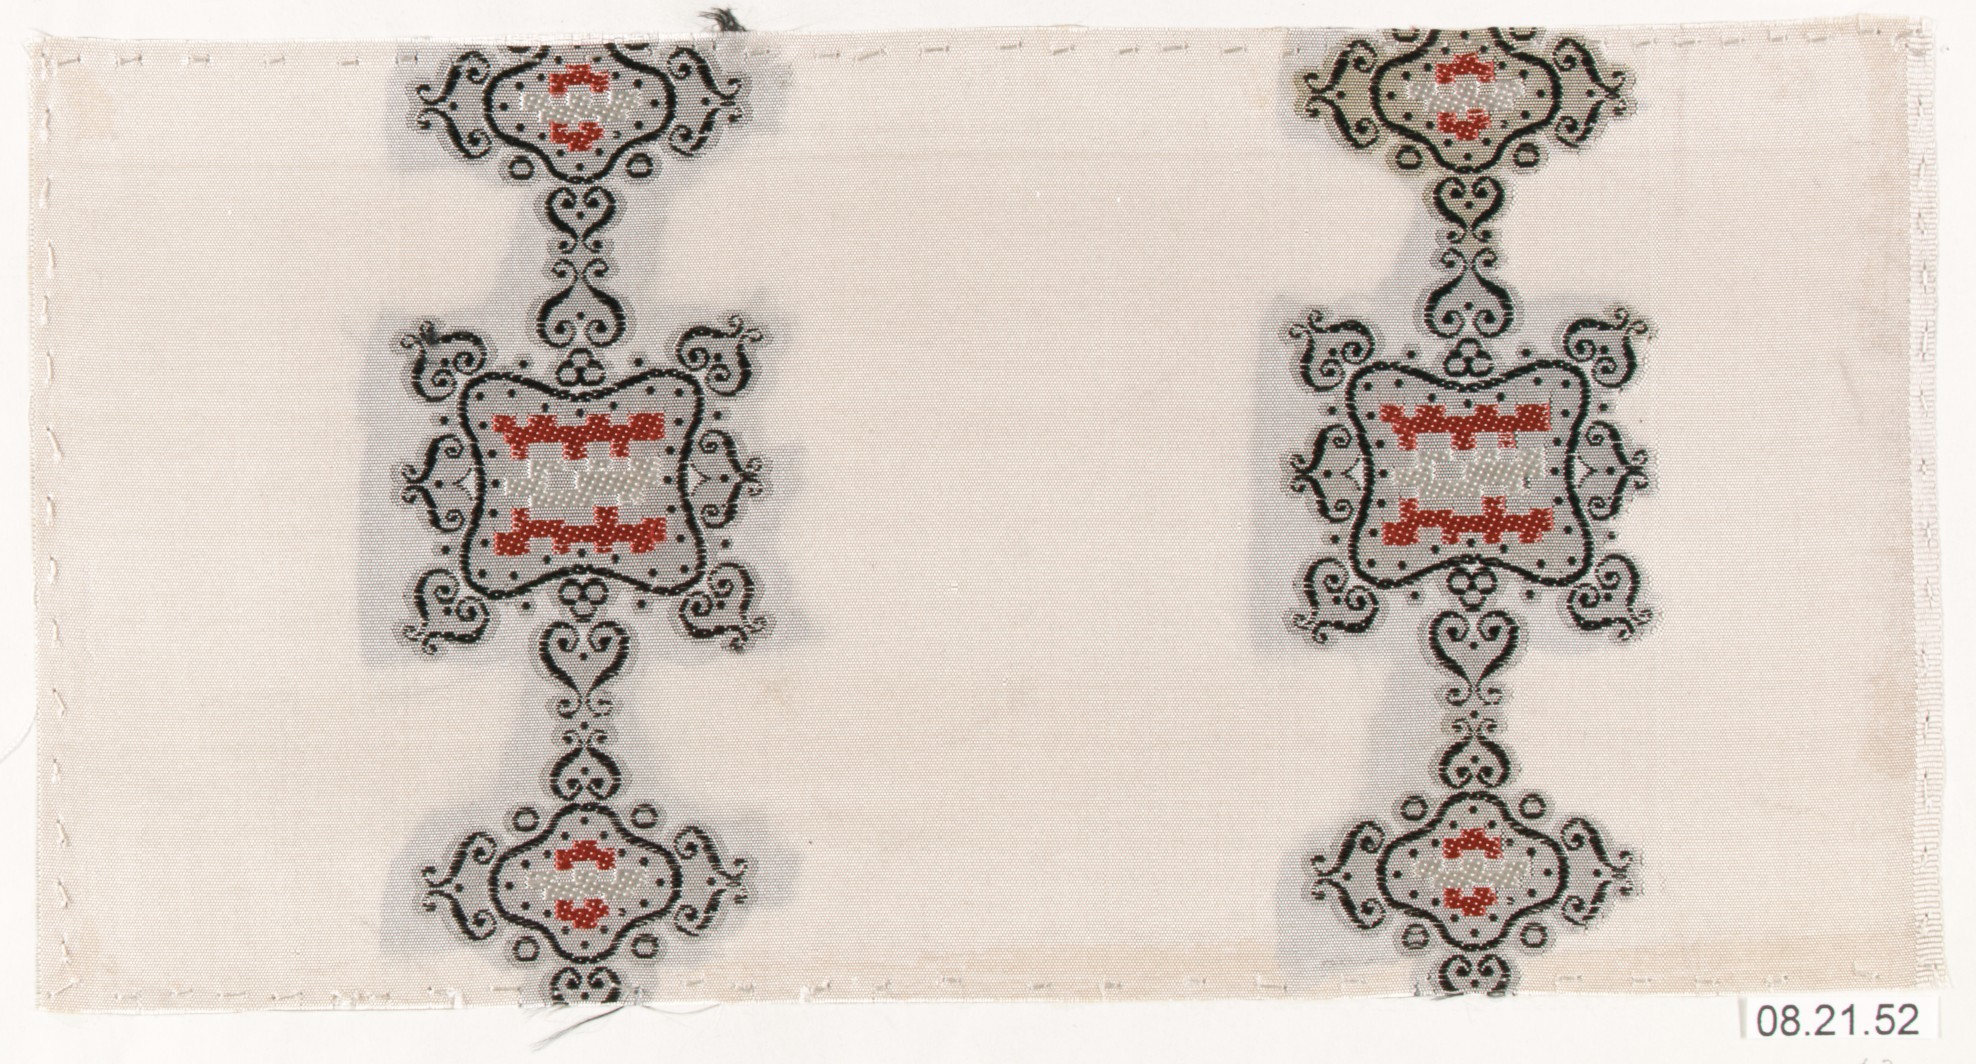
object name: textile sample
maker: Anonymous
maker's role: designer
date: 1900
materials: silk